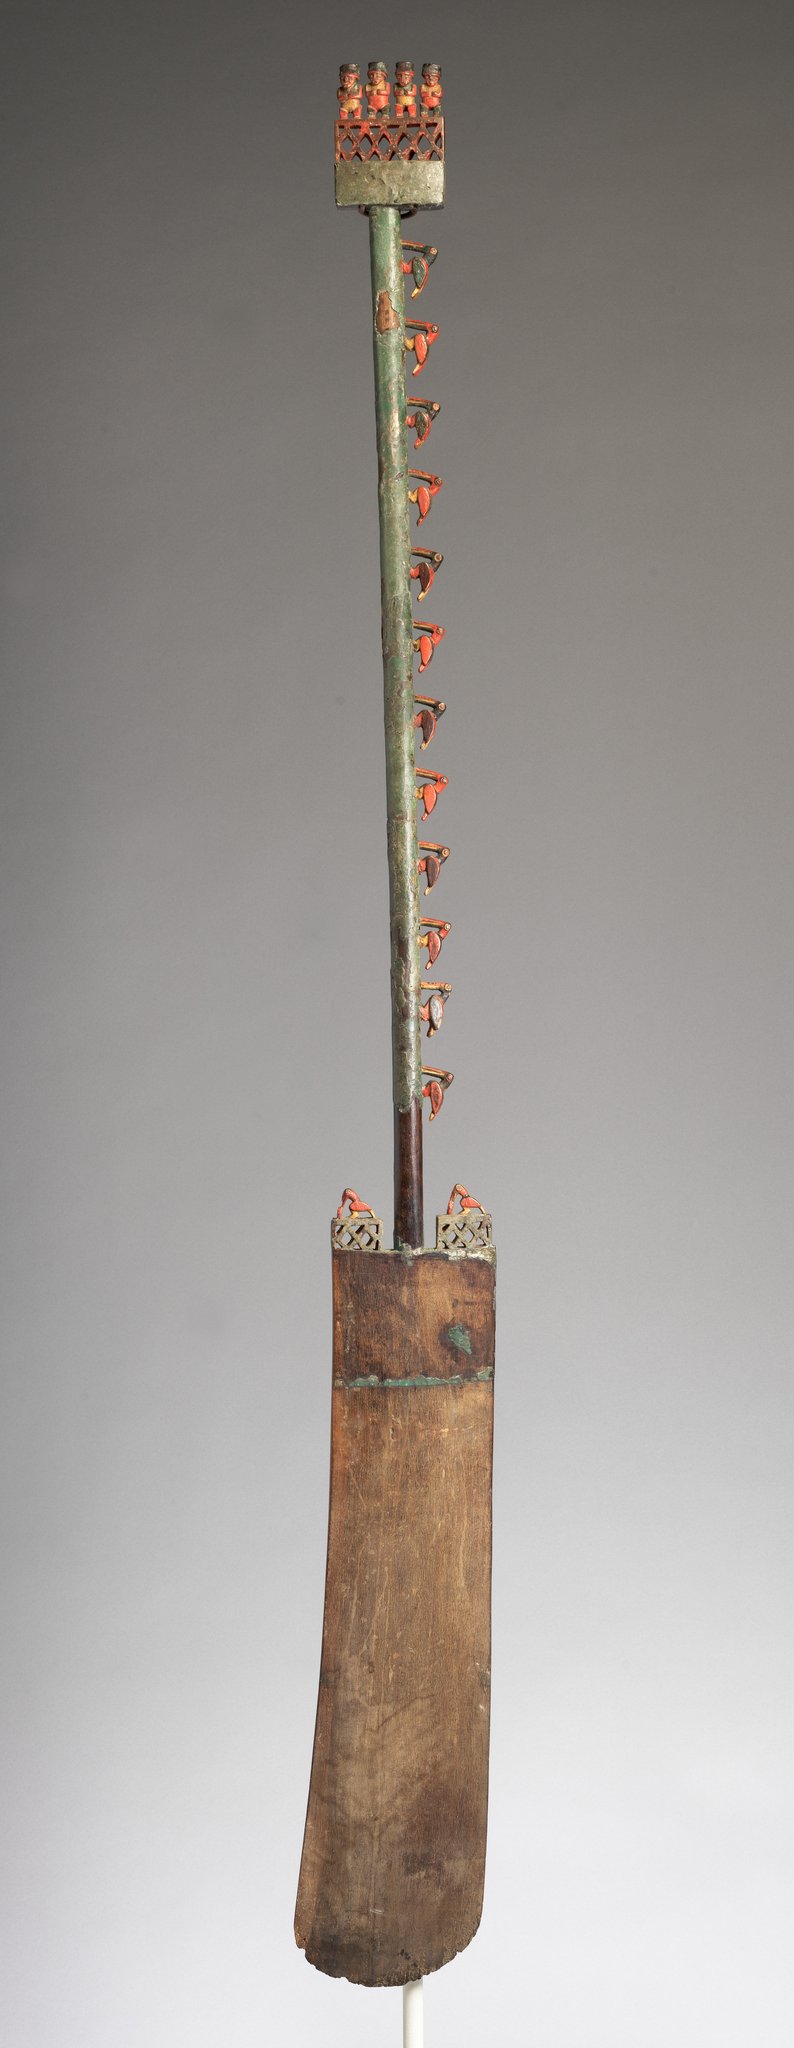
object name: tomb post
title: Ceremonial digging stick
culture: inca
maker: chincha artist(s)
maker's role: artist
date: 1200-1535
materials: metal, paint, silver, wood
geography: peru